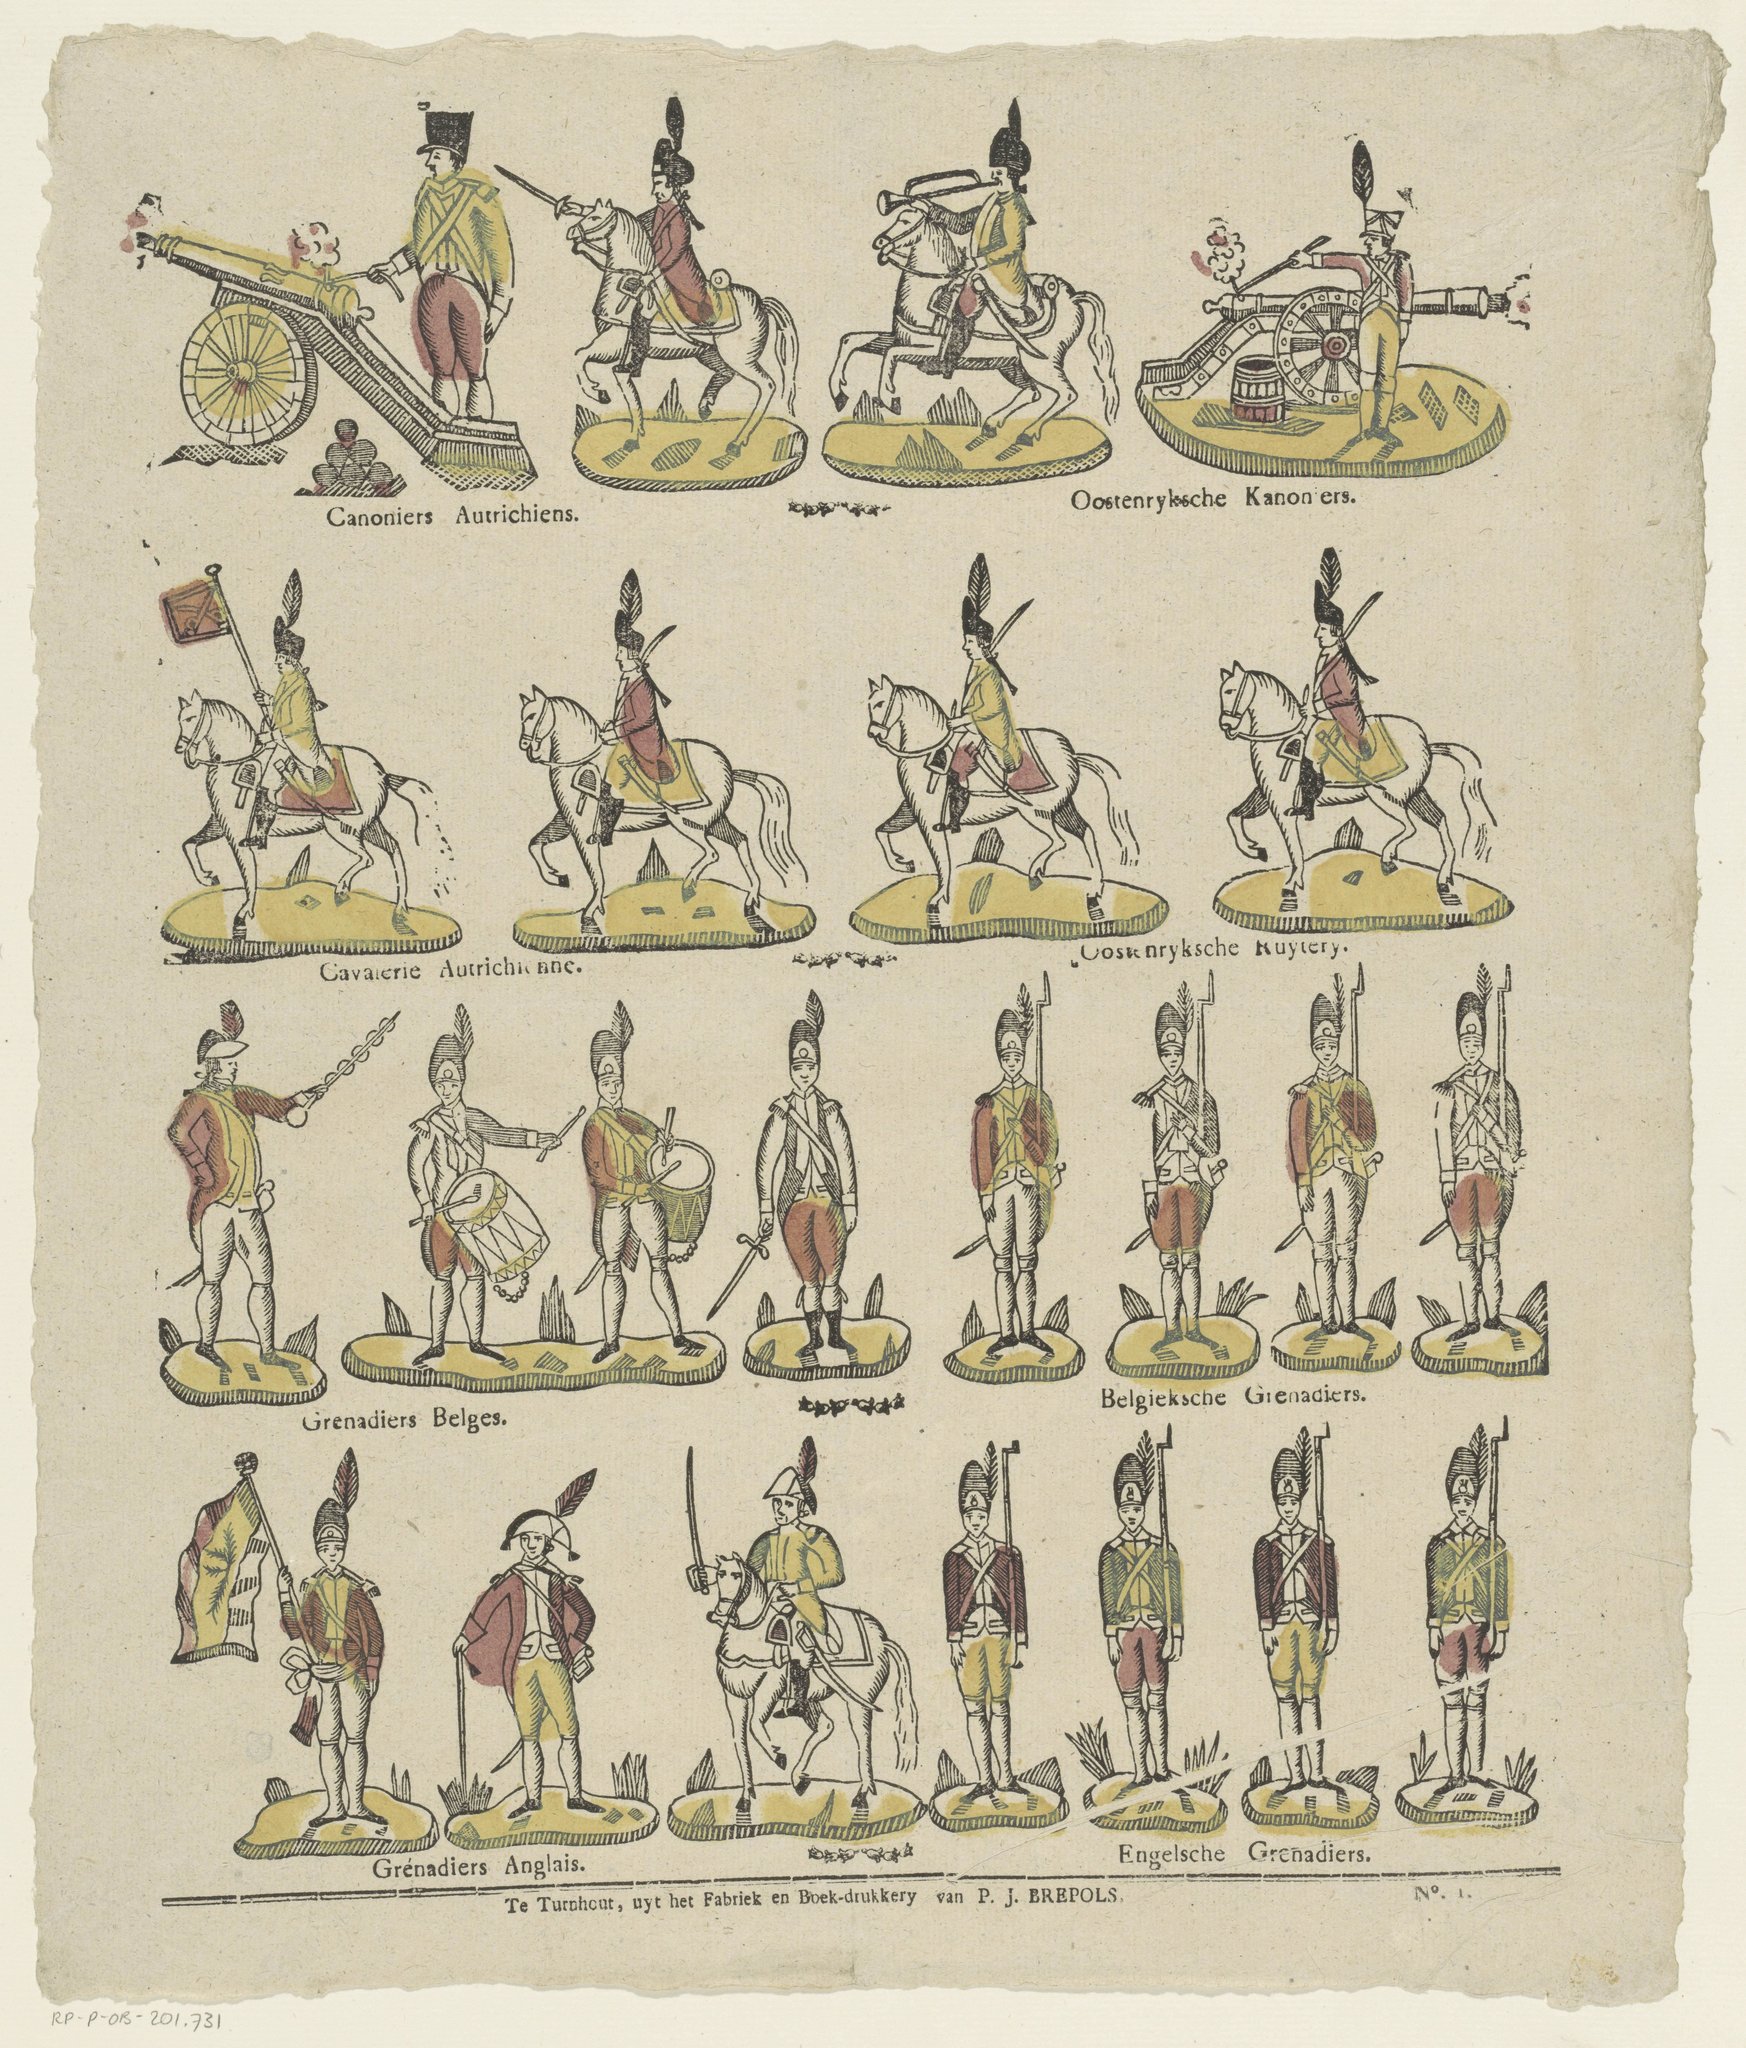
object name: popular print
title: Militairen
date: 1800-1833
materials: paper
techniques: colour, letterpress printing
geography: turnhout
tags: weapons, warfare; military affairs (+ cavalry, horsemen), the soldier; the soldier's life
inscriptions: collector's mark: Lugt 2760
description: Blad met 4 horizontale rijen met met in totaal 23 militairen, te paard, met wapens en met vlaggen uit Oostenrijk, België en Engeland. Onder de voorstellingen onderschriften in het Nederlands en in het Frans. Genummerd rechtsonder: No. 1.